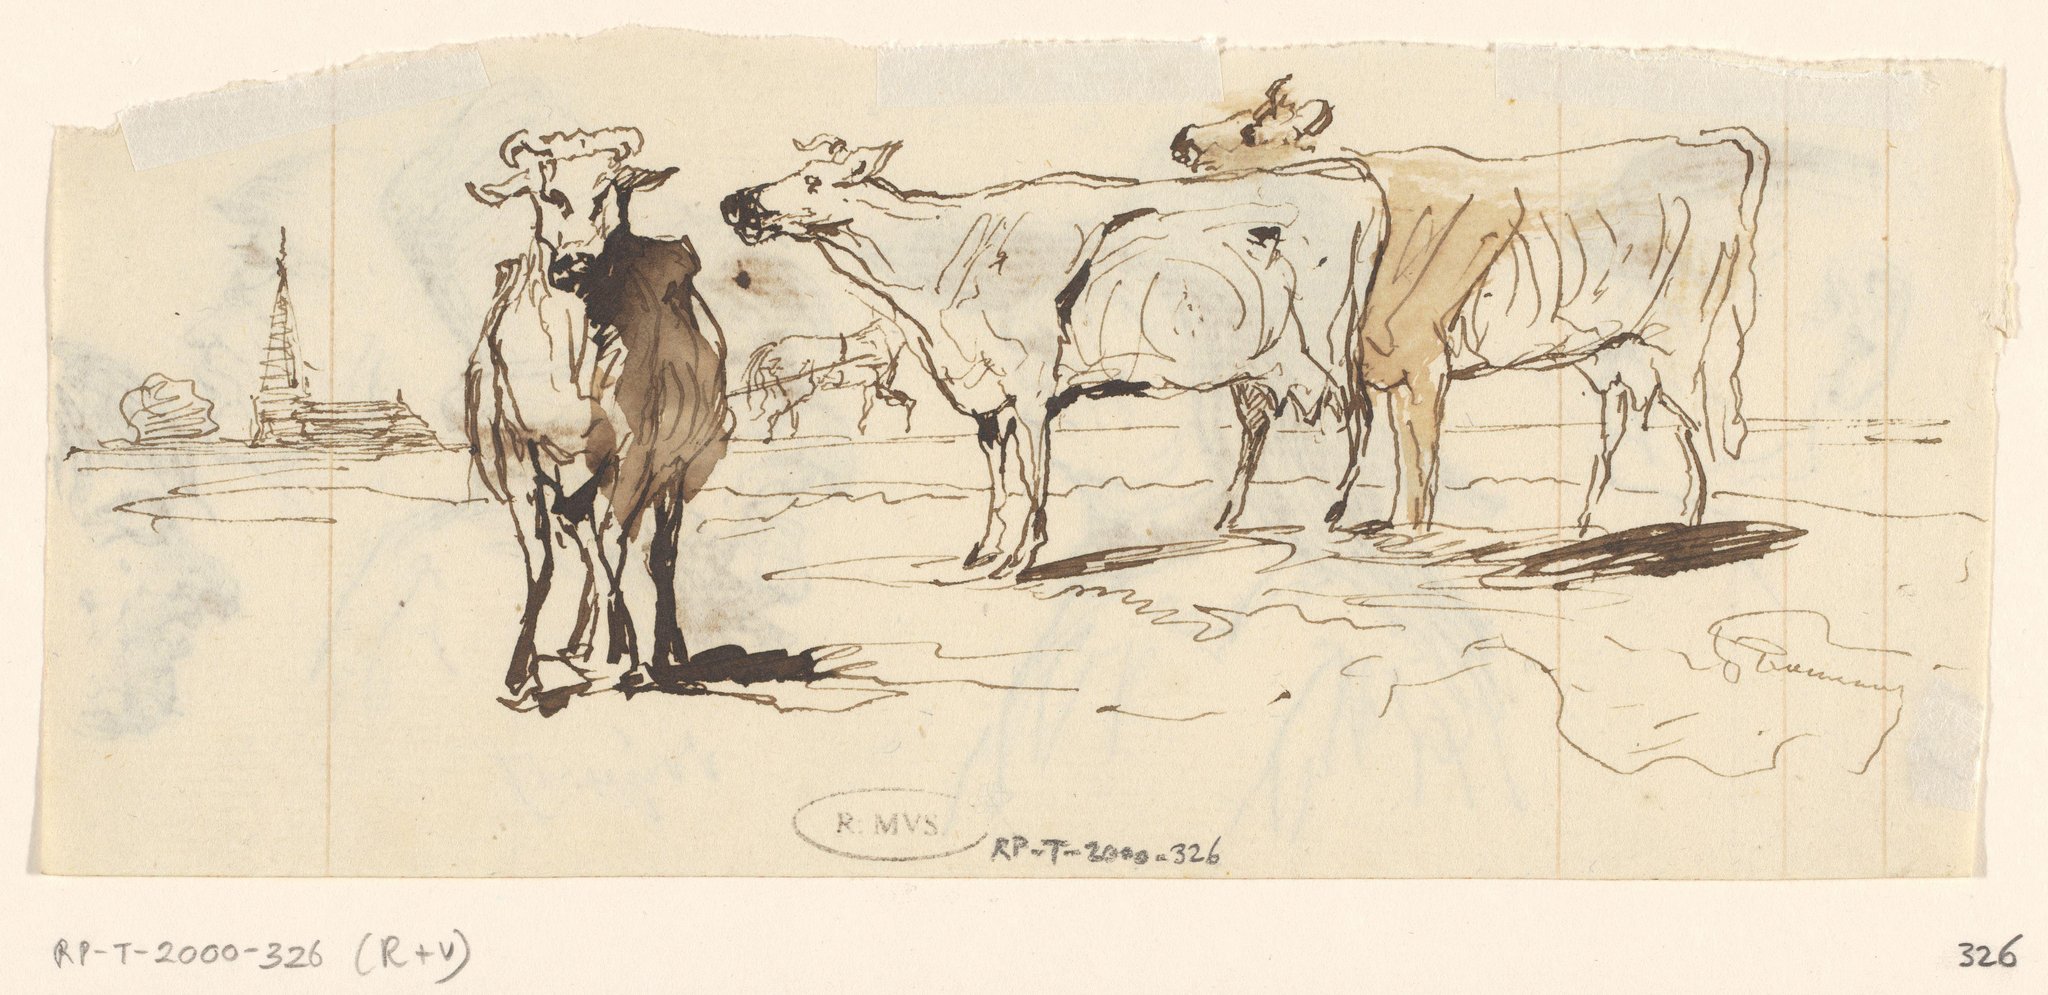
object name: drawing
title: Koeien in de wei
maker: johannes tavenraat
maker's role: draughtsman, painter, print maker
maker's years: 1809-1881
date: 1840-1880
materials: ink, paper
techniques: brush, pen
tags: cow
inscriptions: signature: ‘Tavenraat’, collector's mark: Lugt 2228